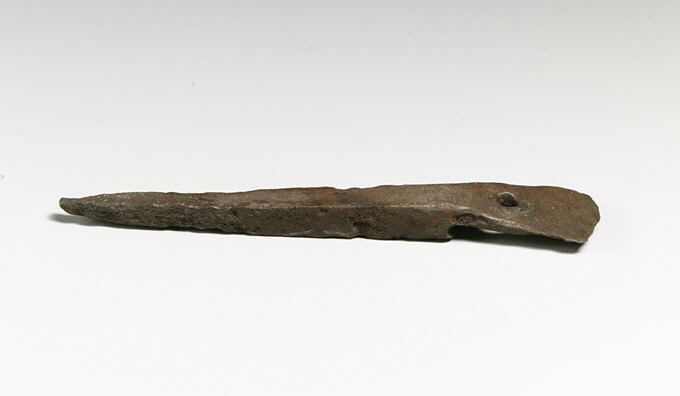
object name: spear spike, holdfast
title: Spear-spike, holdfast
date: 7000 BCE-330 CE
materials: bronze